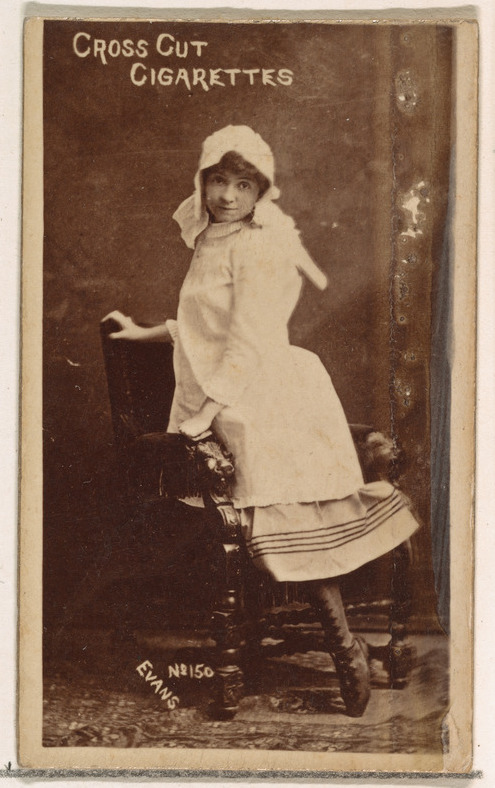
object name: print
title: Card Number 150, Evans, from the Actors and Actresses series (N145-1) issued by Duke Sons & Co. to promote Cross Cut Cigarettes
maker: w. duke, sons & co.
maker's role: publisher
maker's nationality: american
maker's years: 1870-1920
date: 1880-1889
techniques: albumen silver print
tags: portraits,women,actresses